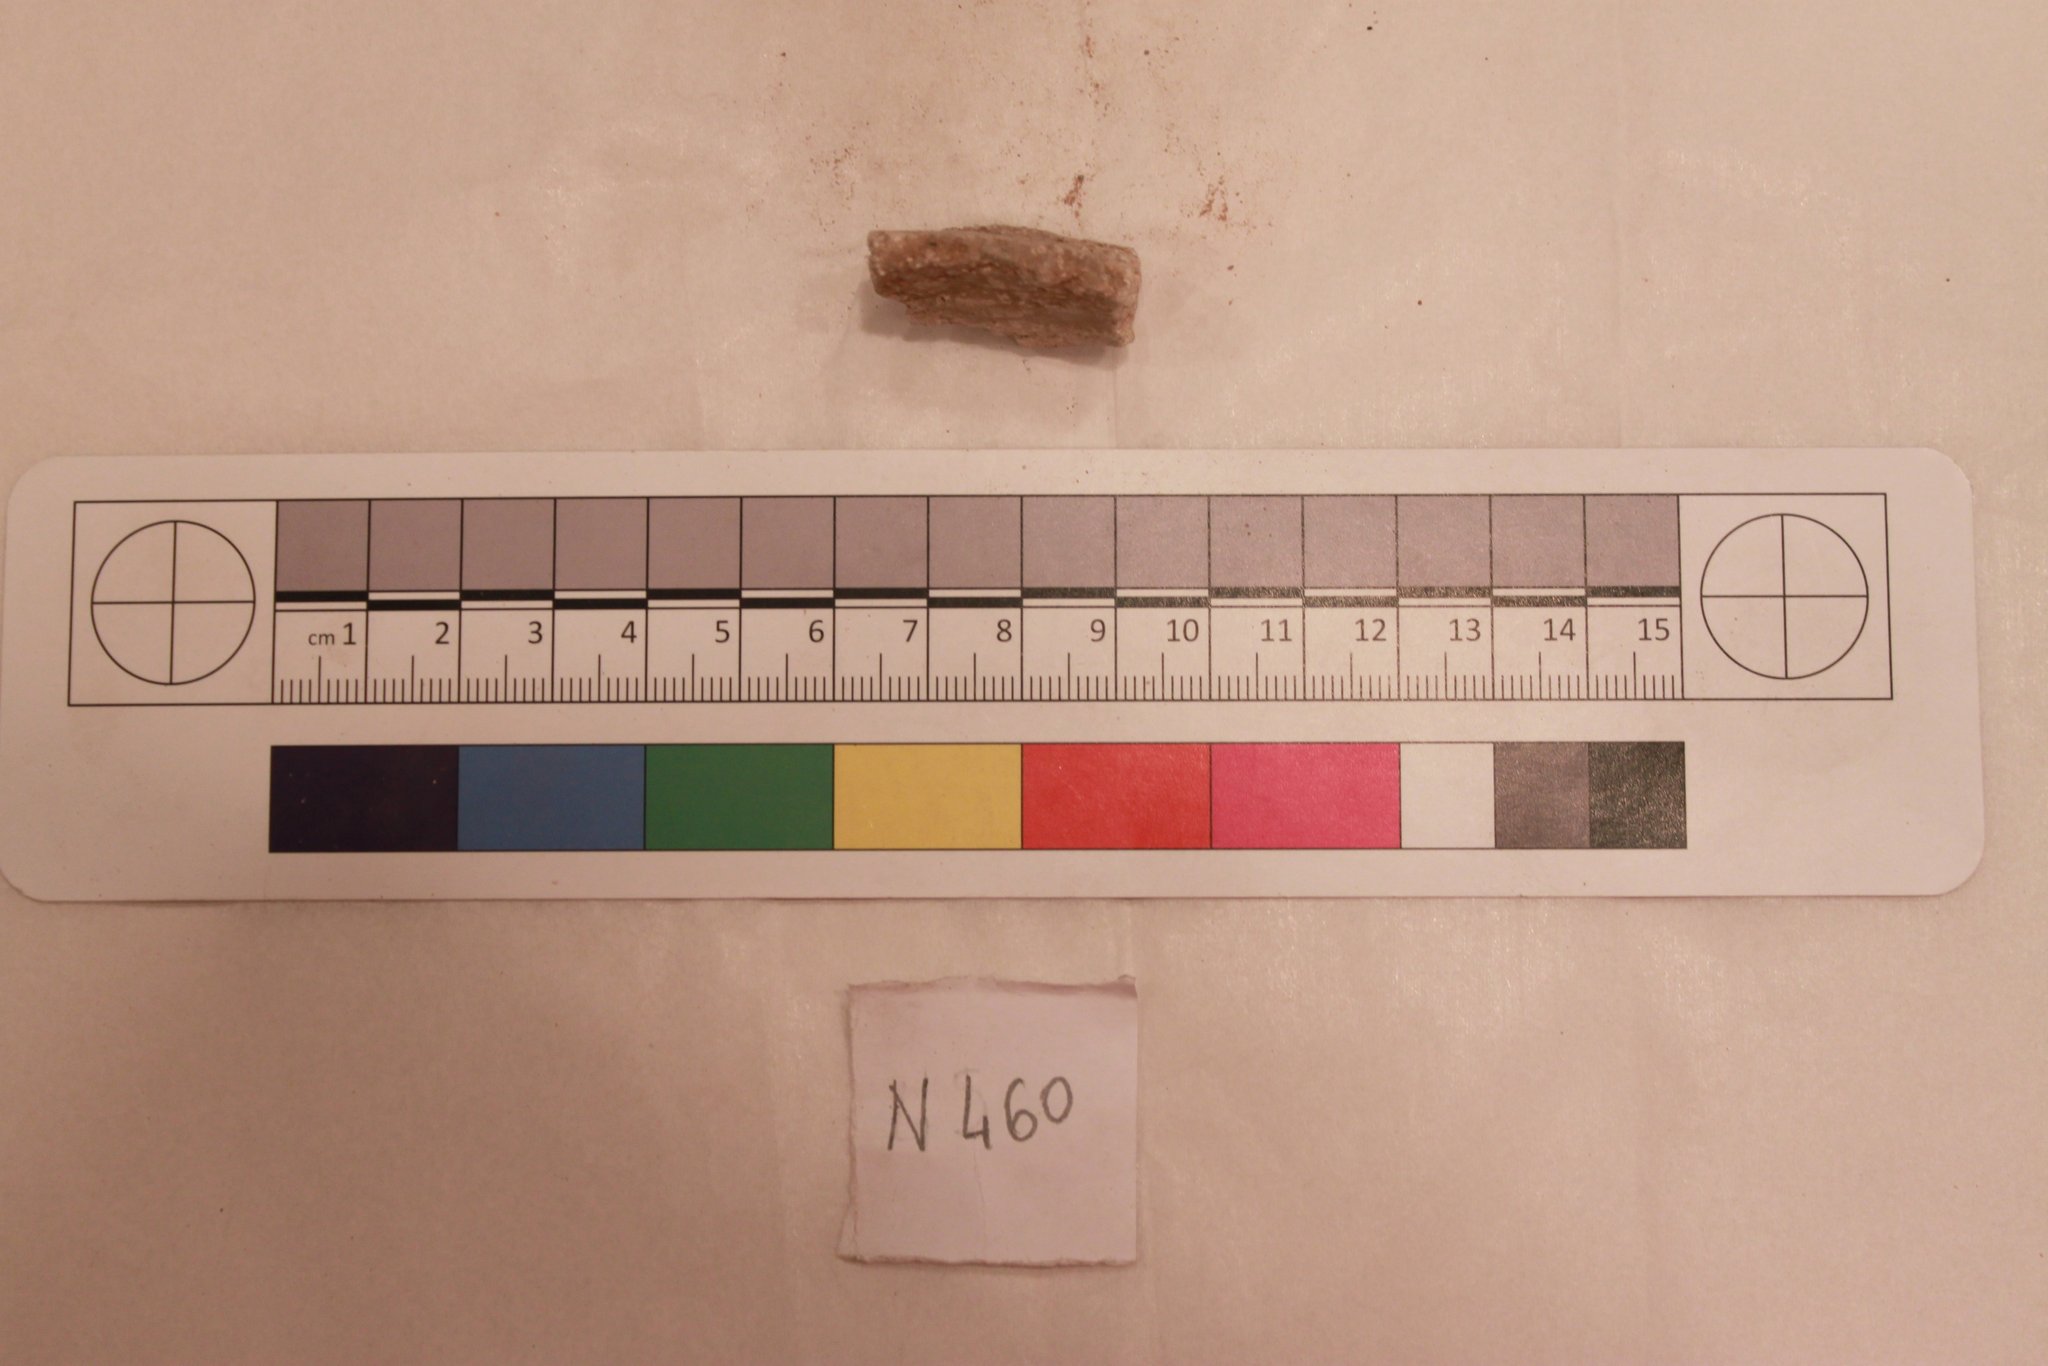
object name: fragment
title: Stucco Fragment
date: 701-1200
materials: plaster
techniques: carving, painting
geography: iran